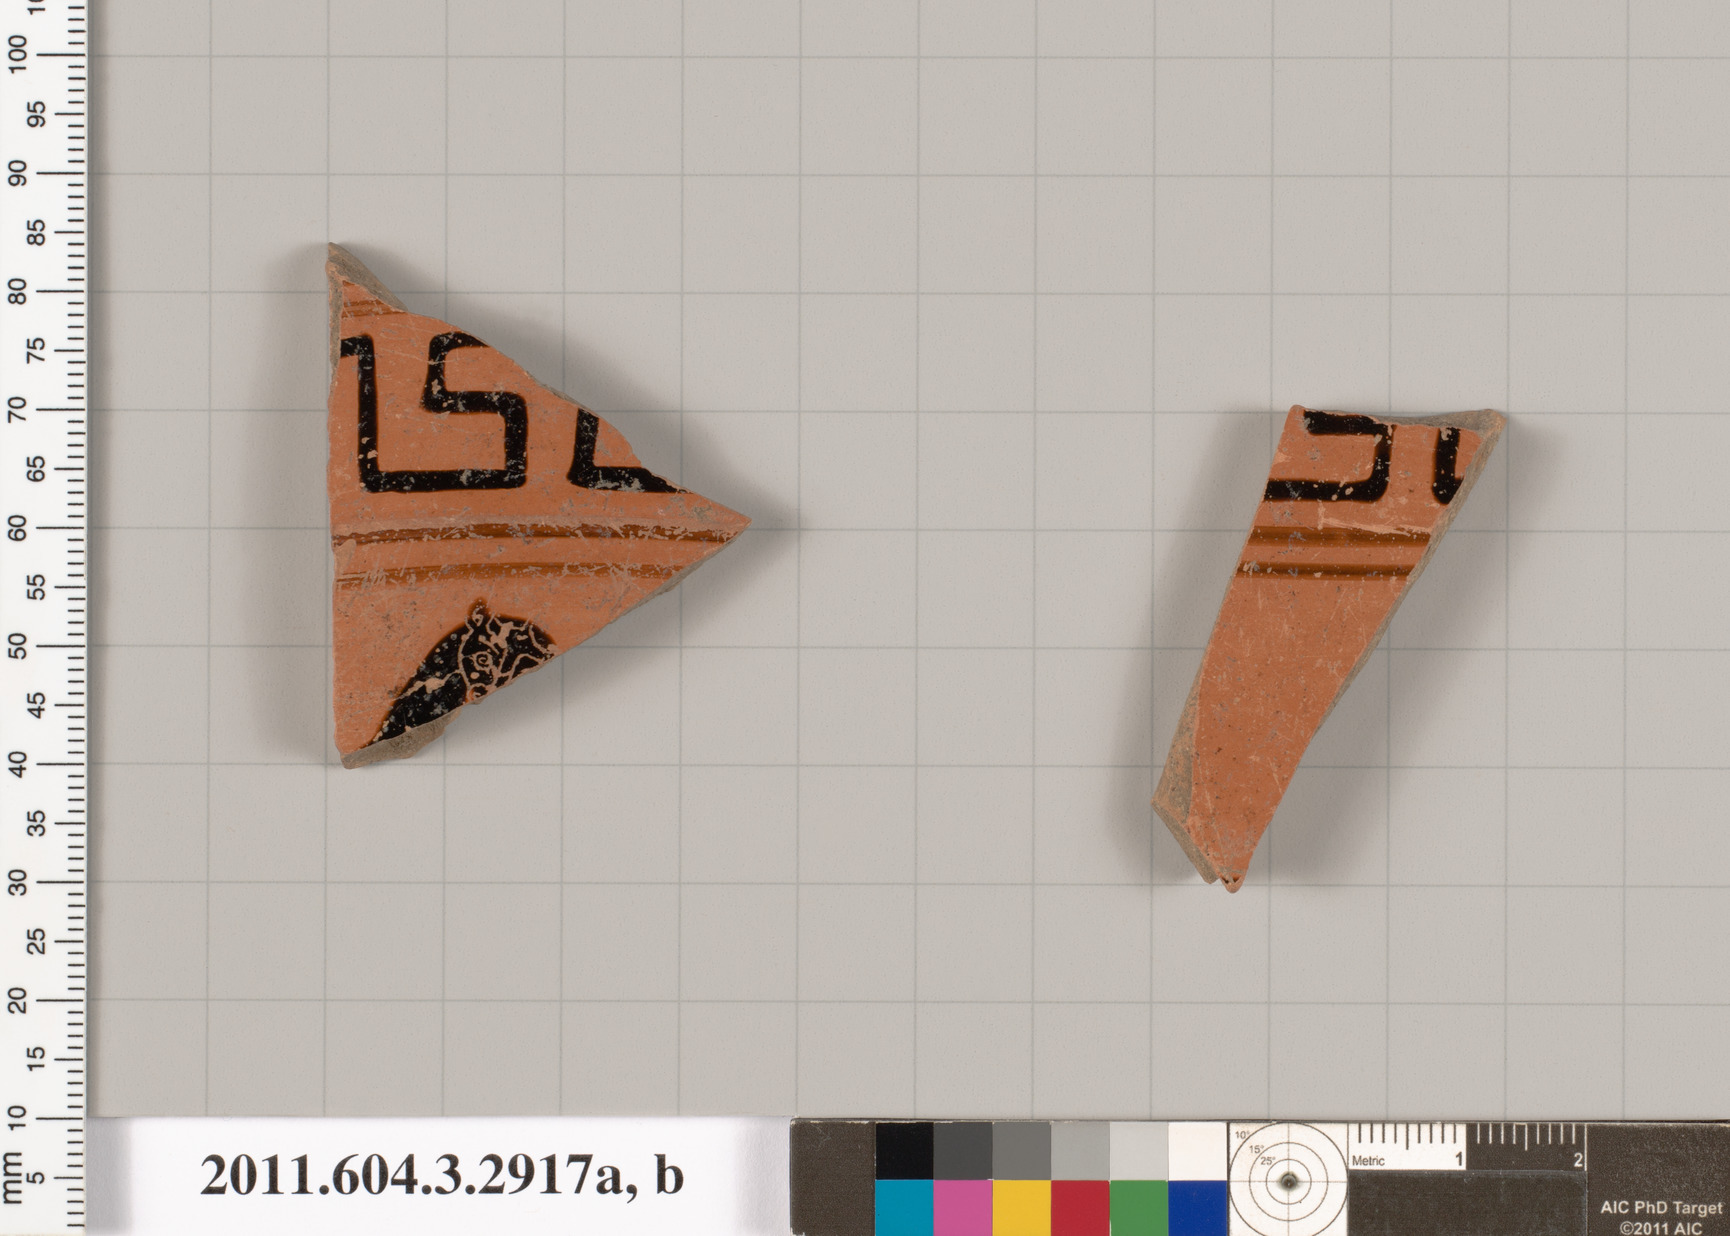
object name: neck amphora fragment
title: Terracotta fragments of a neck-amphora (jar)?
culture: greek, attic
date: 550-526 BCE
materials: terracotta